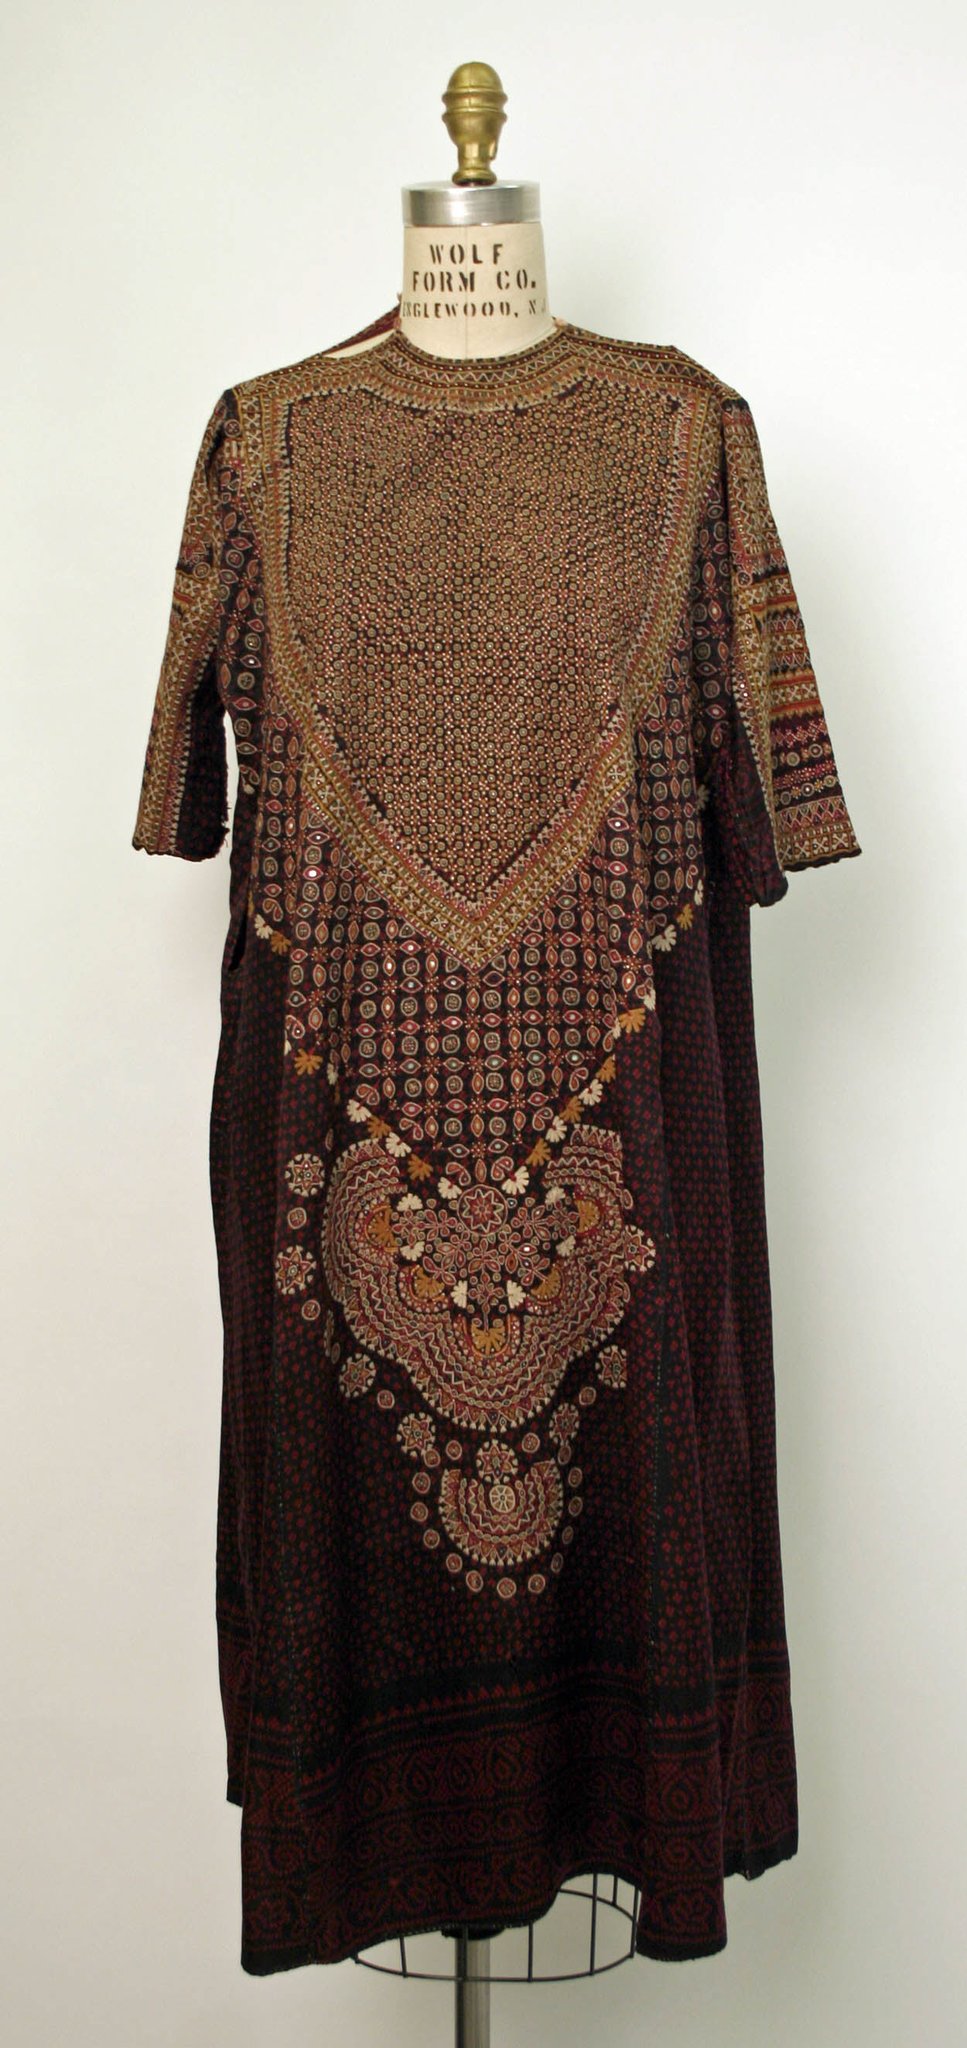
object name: shirt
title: Kurta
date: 1801-1900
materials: silk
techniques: embroidery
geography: india